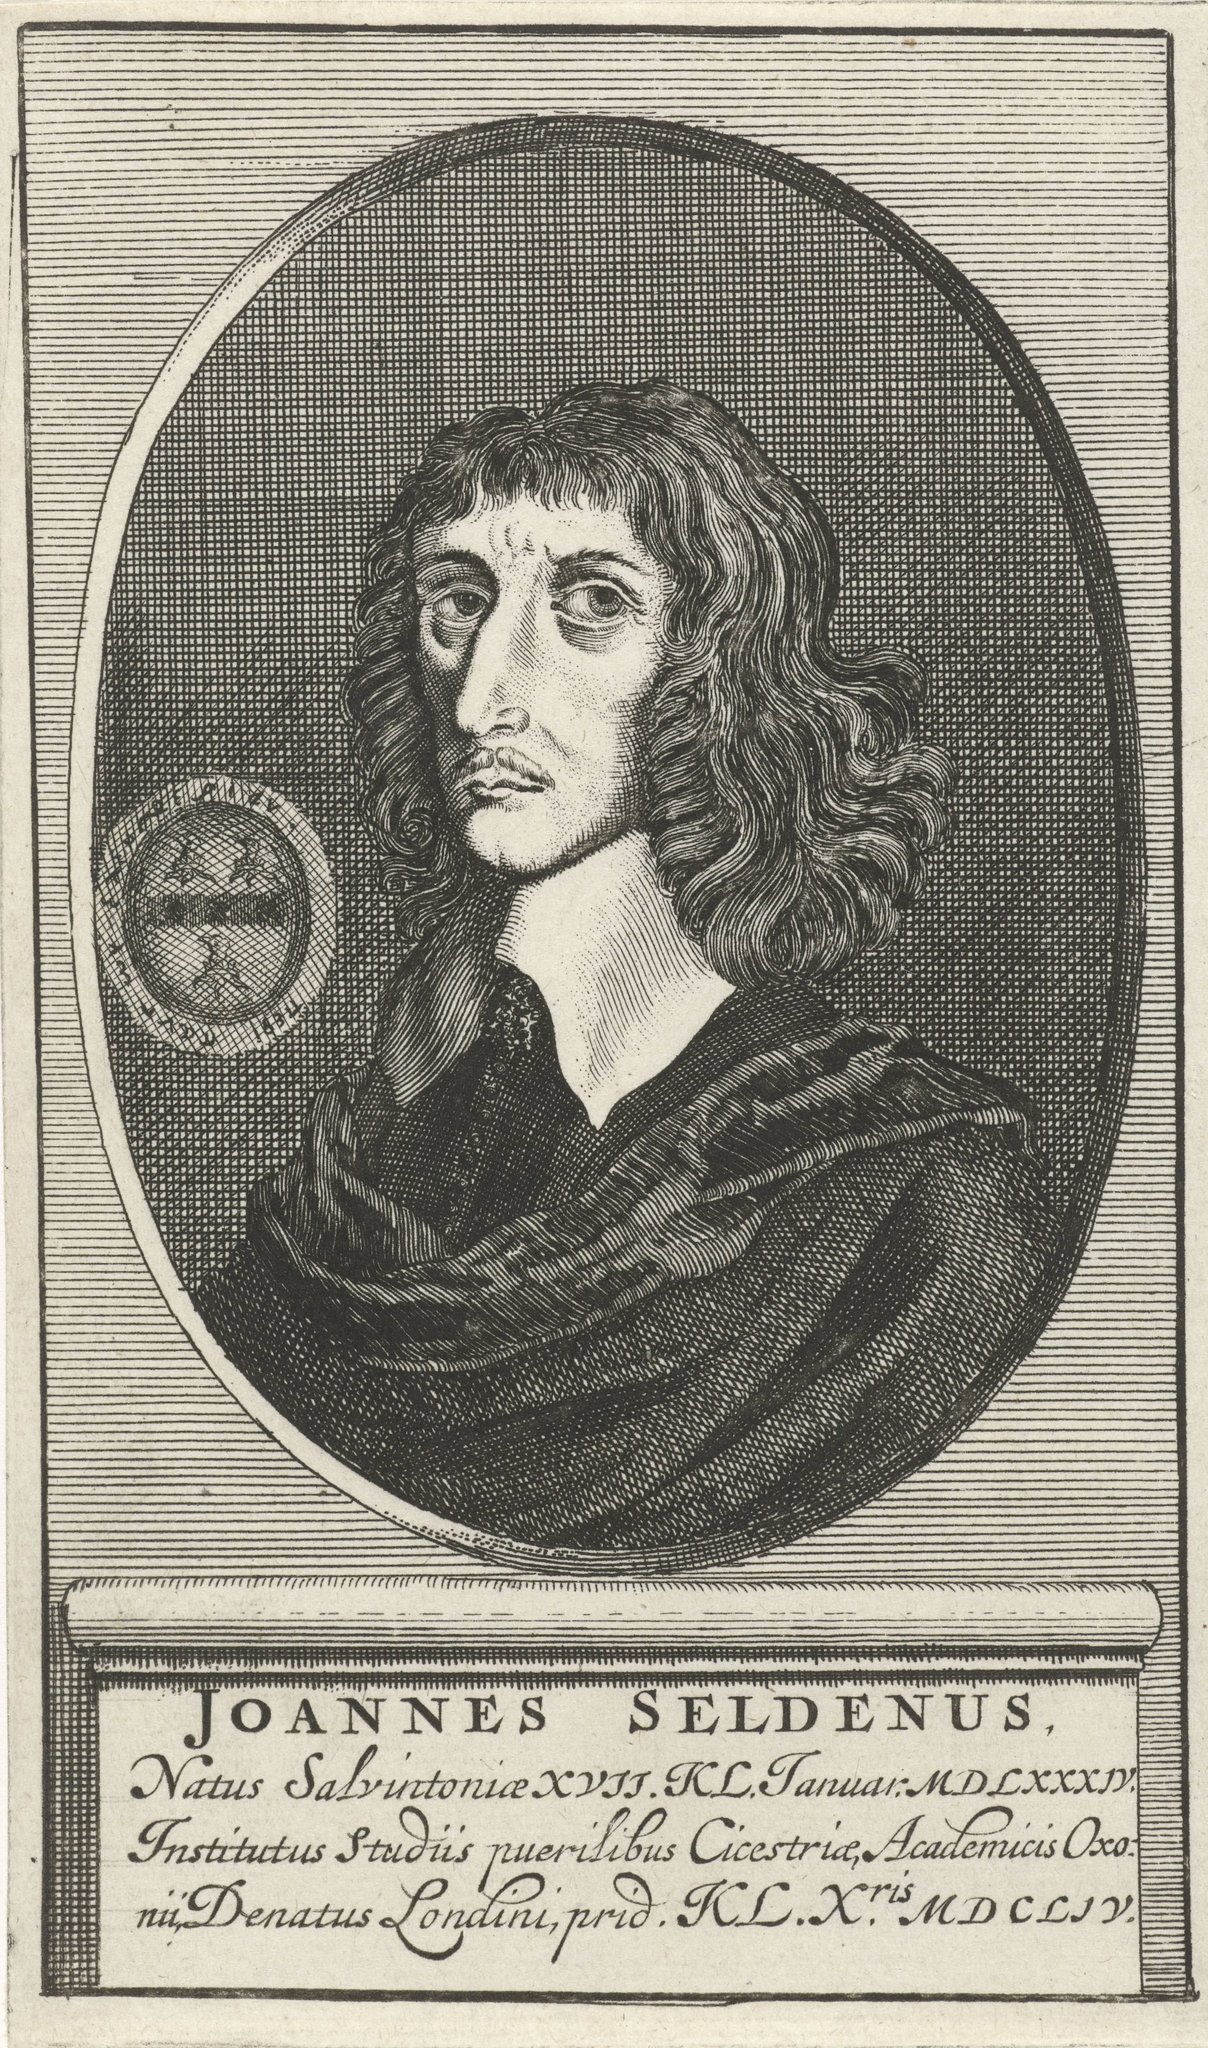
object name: print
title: Portret van de Engelse jurist John Seldenus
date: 1680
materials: paper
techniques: etching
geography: amsterdam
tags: armorial bearing, heraldry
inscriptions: collector's mark: Lugt 2228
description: Portret opgenomen in: Selden, John. De Dis Syris Syntagmata II. Amsterdam: Hendrick en Dirk Boom, 1680.